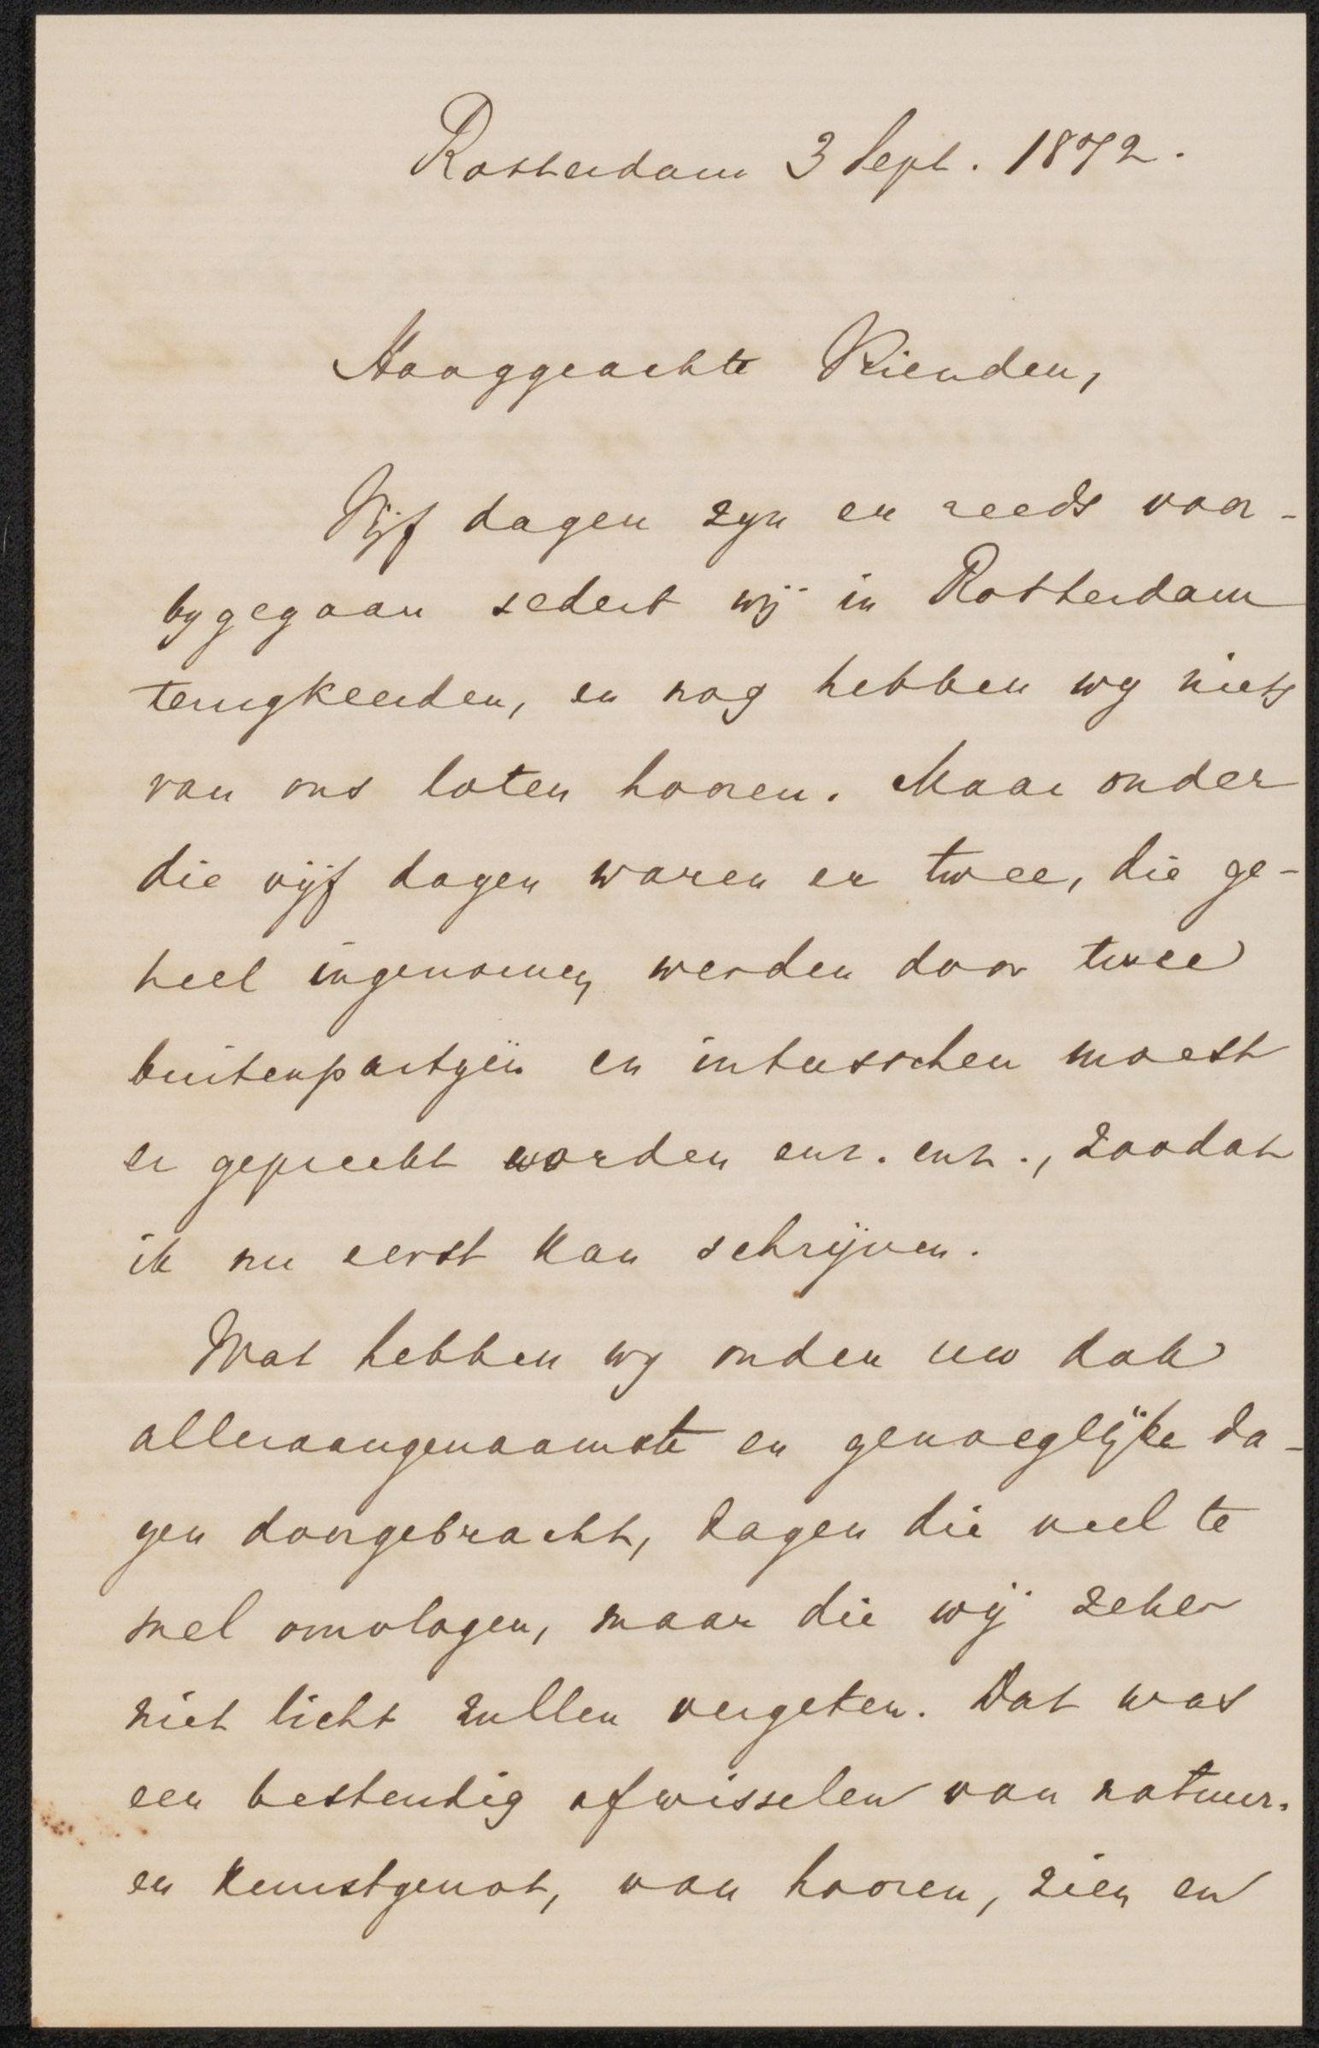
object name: letter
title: Brief aan Ary Johannes Lamme en Adriana Lamme-van Geller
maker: cornelis petrus tiele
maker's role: theoloog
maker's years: 1830-1902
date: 1872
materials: ink, paper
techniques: pen, writing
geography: rotterdam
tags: adriana lamme-van geller, dordrecht, draughtsman, ary johannes lamme, rotterdam, print maker, dirk arie lamme, literature ~ arts, photography, cinematography, historical persons (portraits and scenes from the life)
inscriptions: collector's mark: Lugt 2228